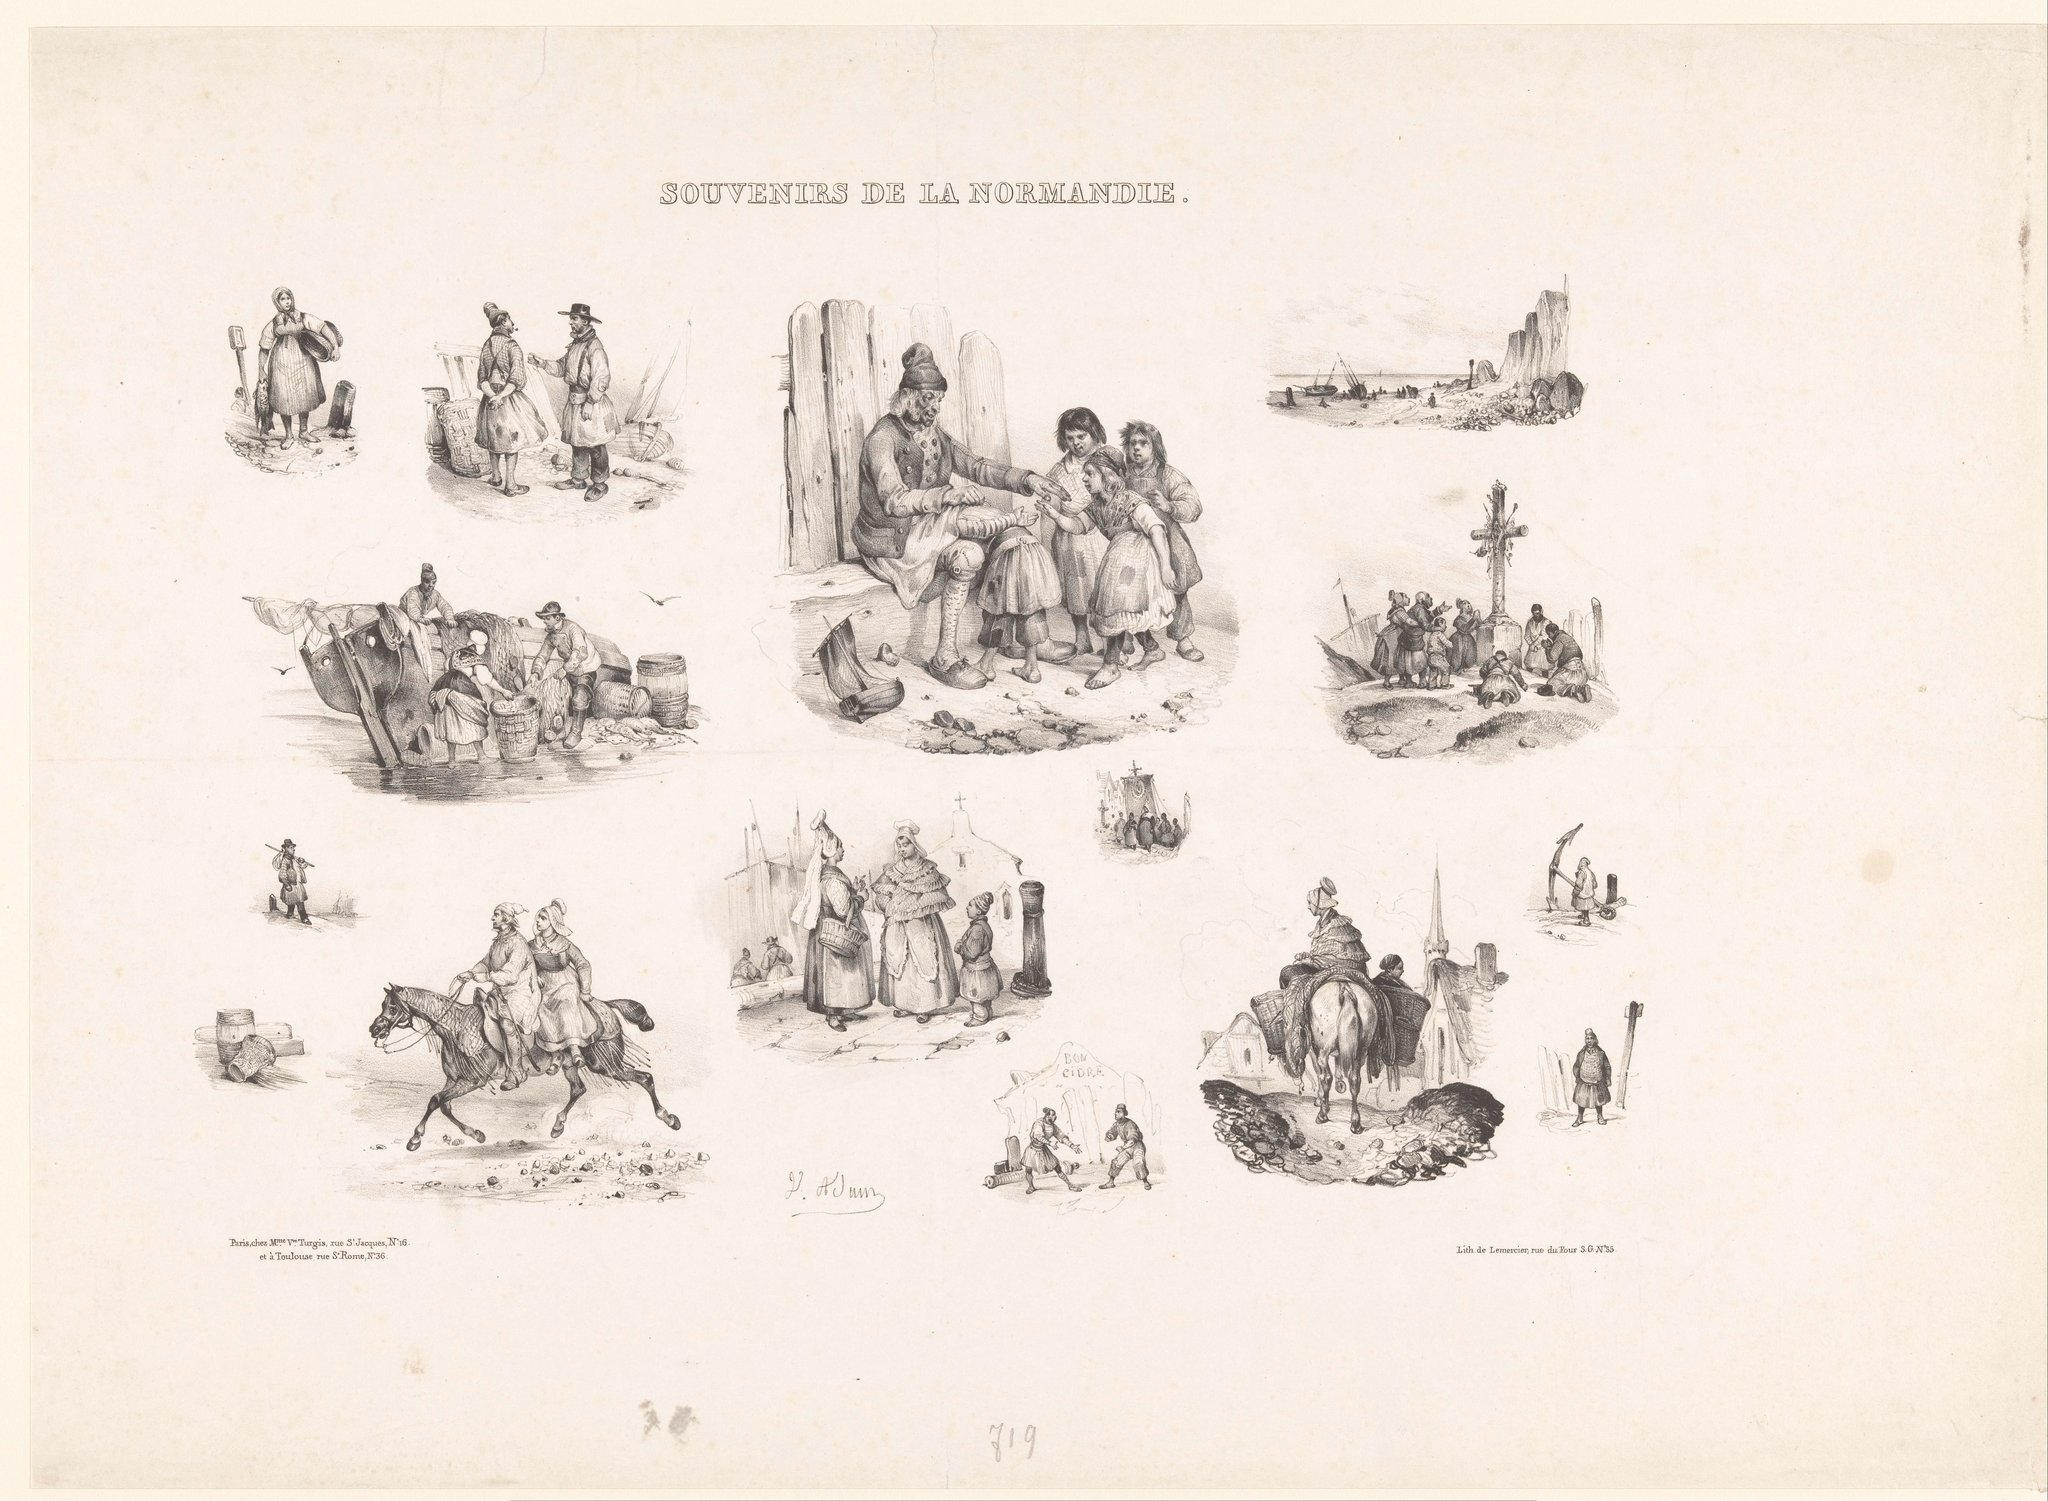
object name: print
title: Souvenirs de la Normandie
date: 1833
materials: paper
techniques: lithograph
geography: paris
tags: folklore, the study of popular tradition, fisherman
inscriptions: collector's mark: Lugt 2228, annotation: ‘719’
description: Vijftien voorstellingen van folkore in Normandië, waaronder het vissersleven.